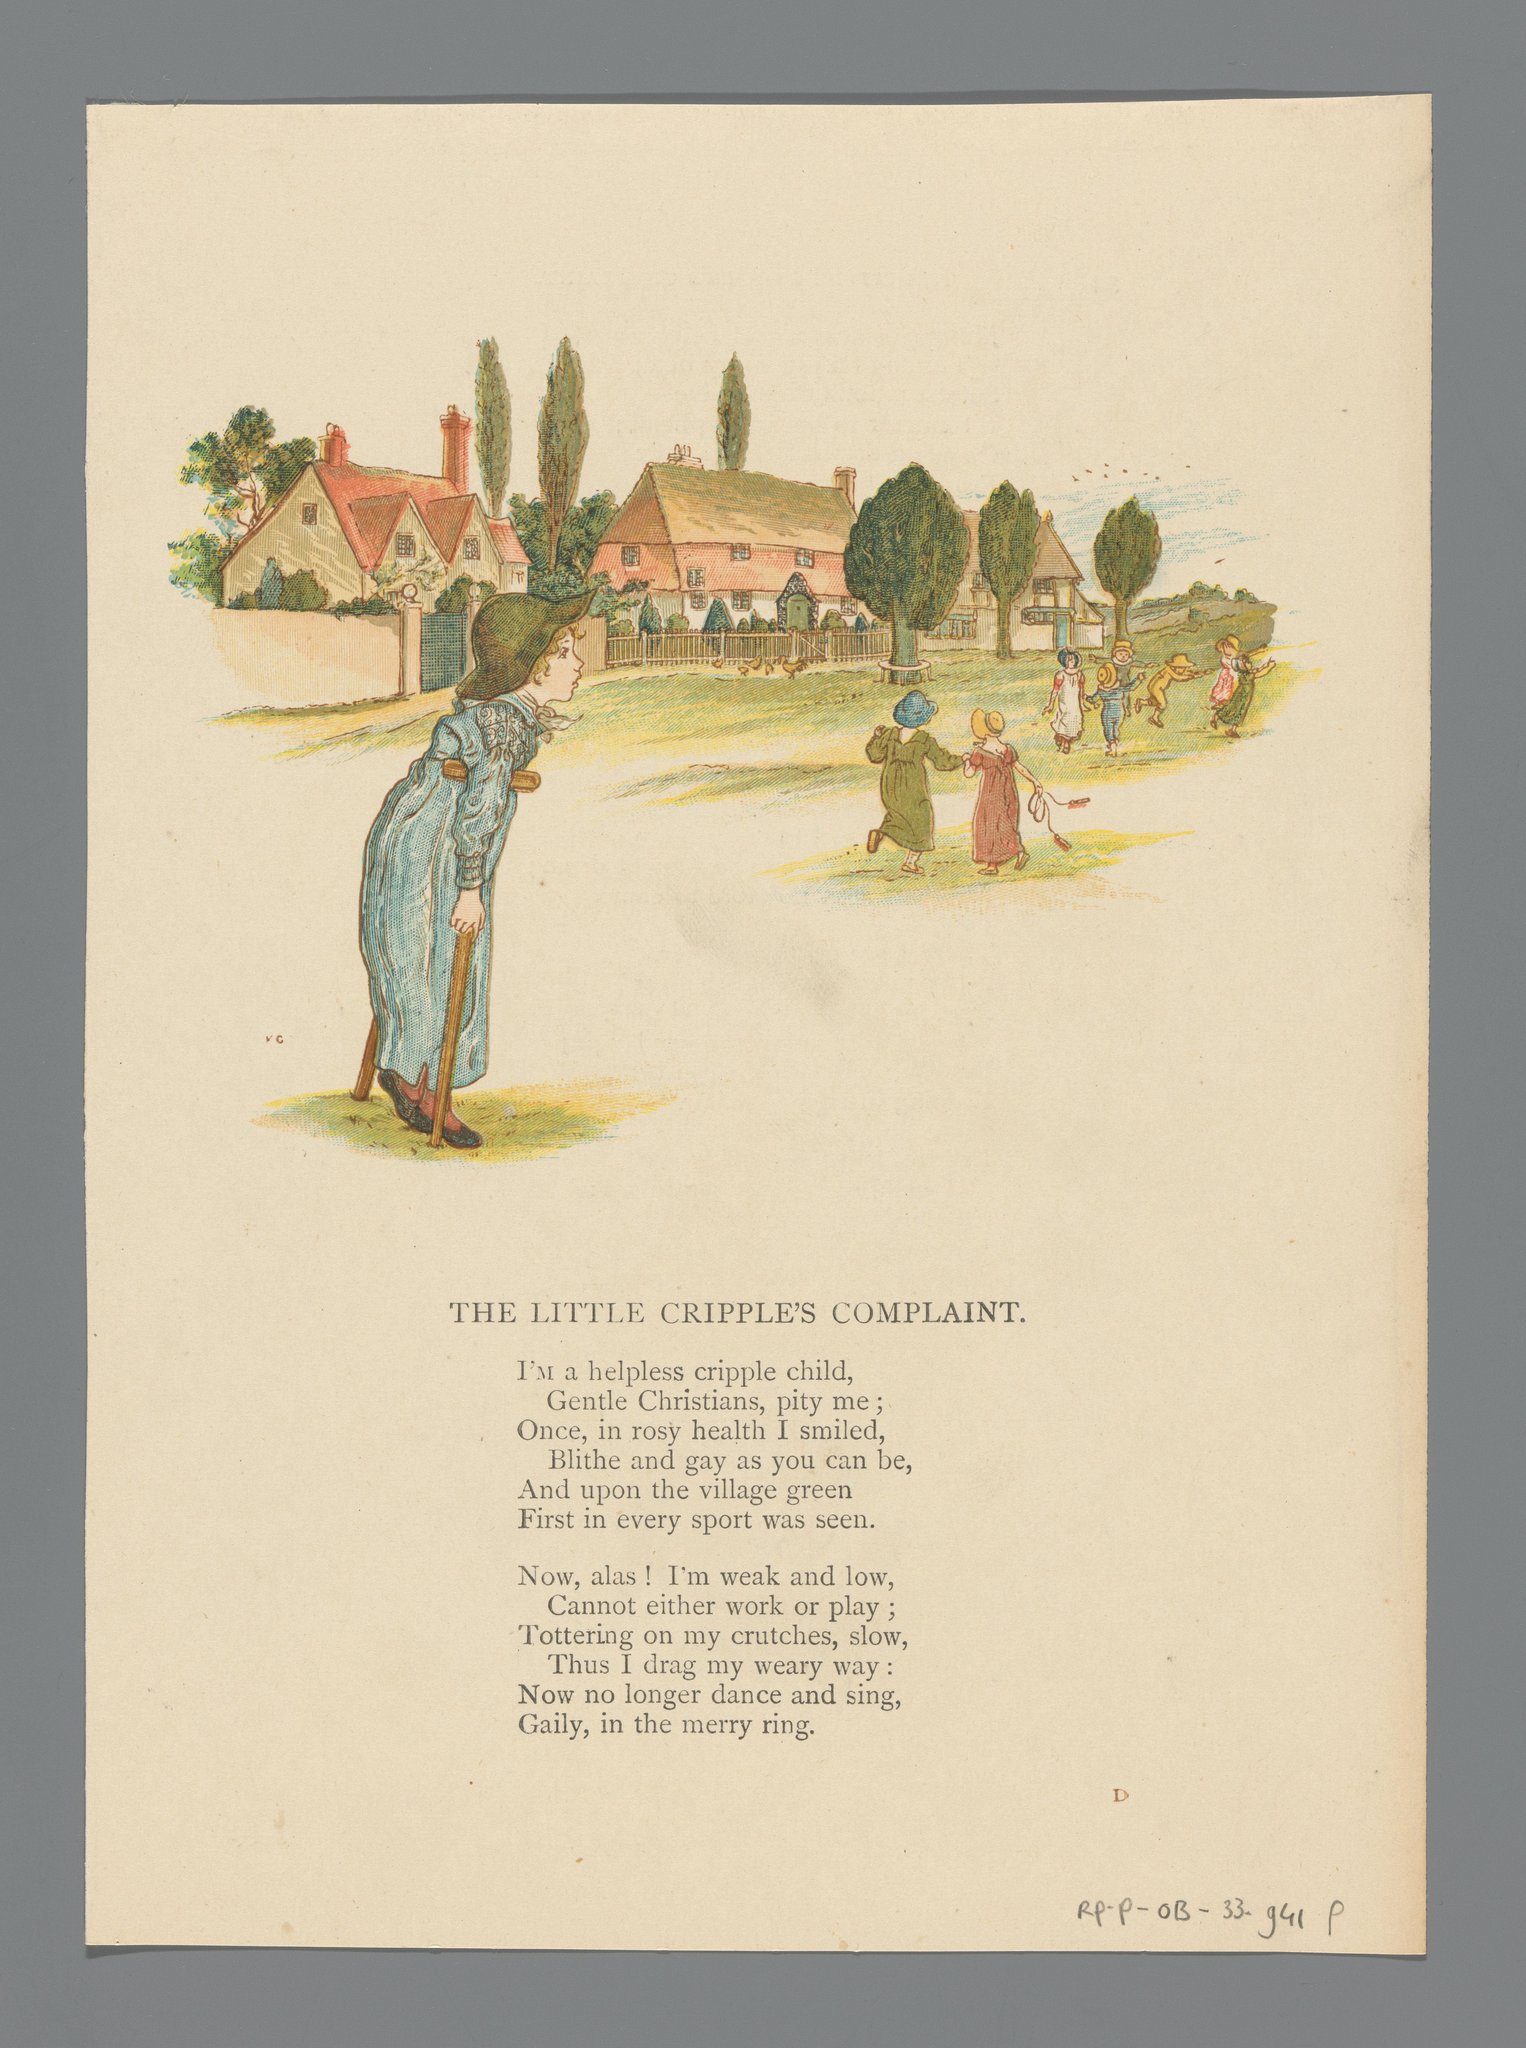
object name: print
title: Kind op krukken bij een groep spelende kinderen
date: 1883-1927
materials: paper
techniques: wood engraving, letterpress printing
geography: london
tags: children's games and plays, crutches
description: Prent uit: Jane en Ann Taylor. Little Ann and other poems. Londen: George Routledge & Sons, [1883], p. 33. Of een latere uitgave.